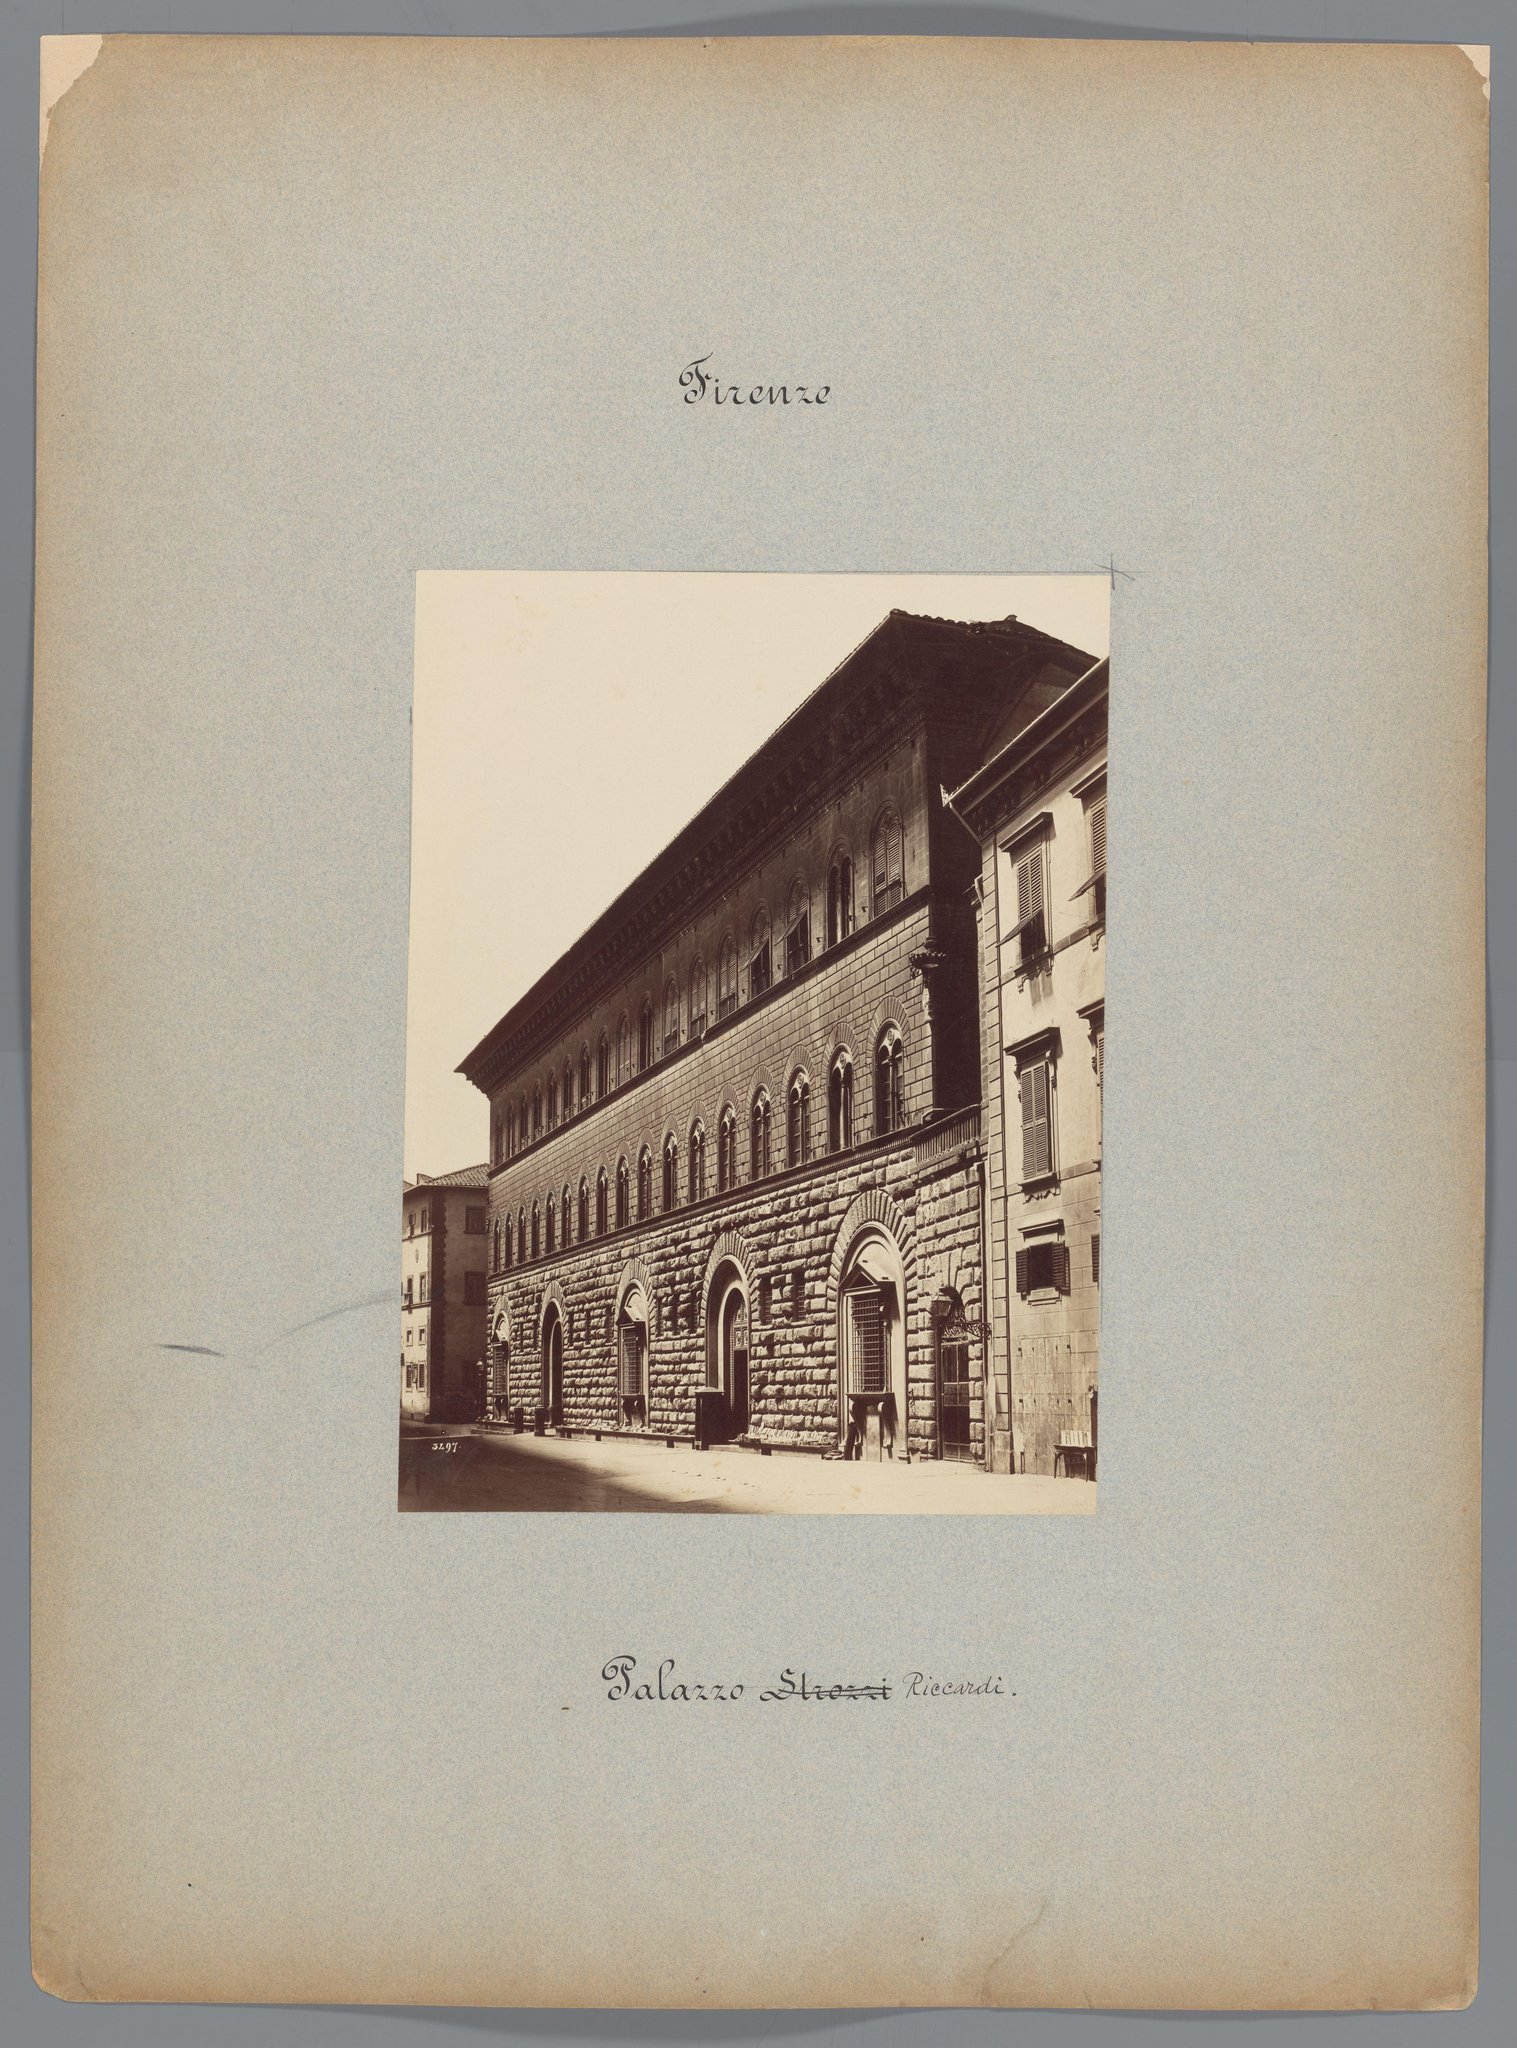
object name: photograph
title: Gezicht op het Palazzo Riccardi te Florence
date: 1865-1900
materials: cardboard, photographic support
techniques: albumen print, calligraphy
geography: florence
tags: palazzo riccardi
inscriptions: : ‘Firenze / Palazzo Riccardi’, : ‘3497.’, signature: ‘ALINARI’